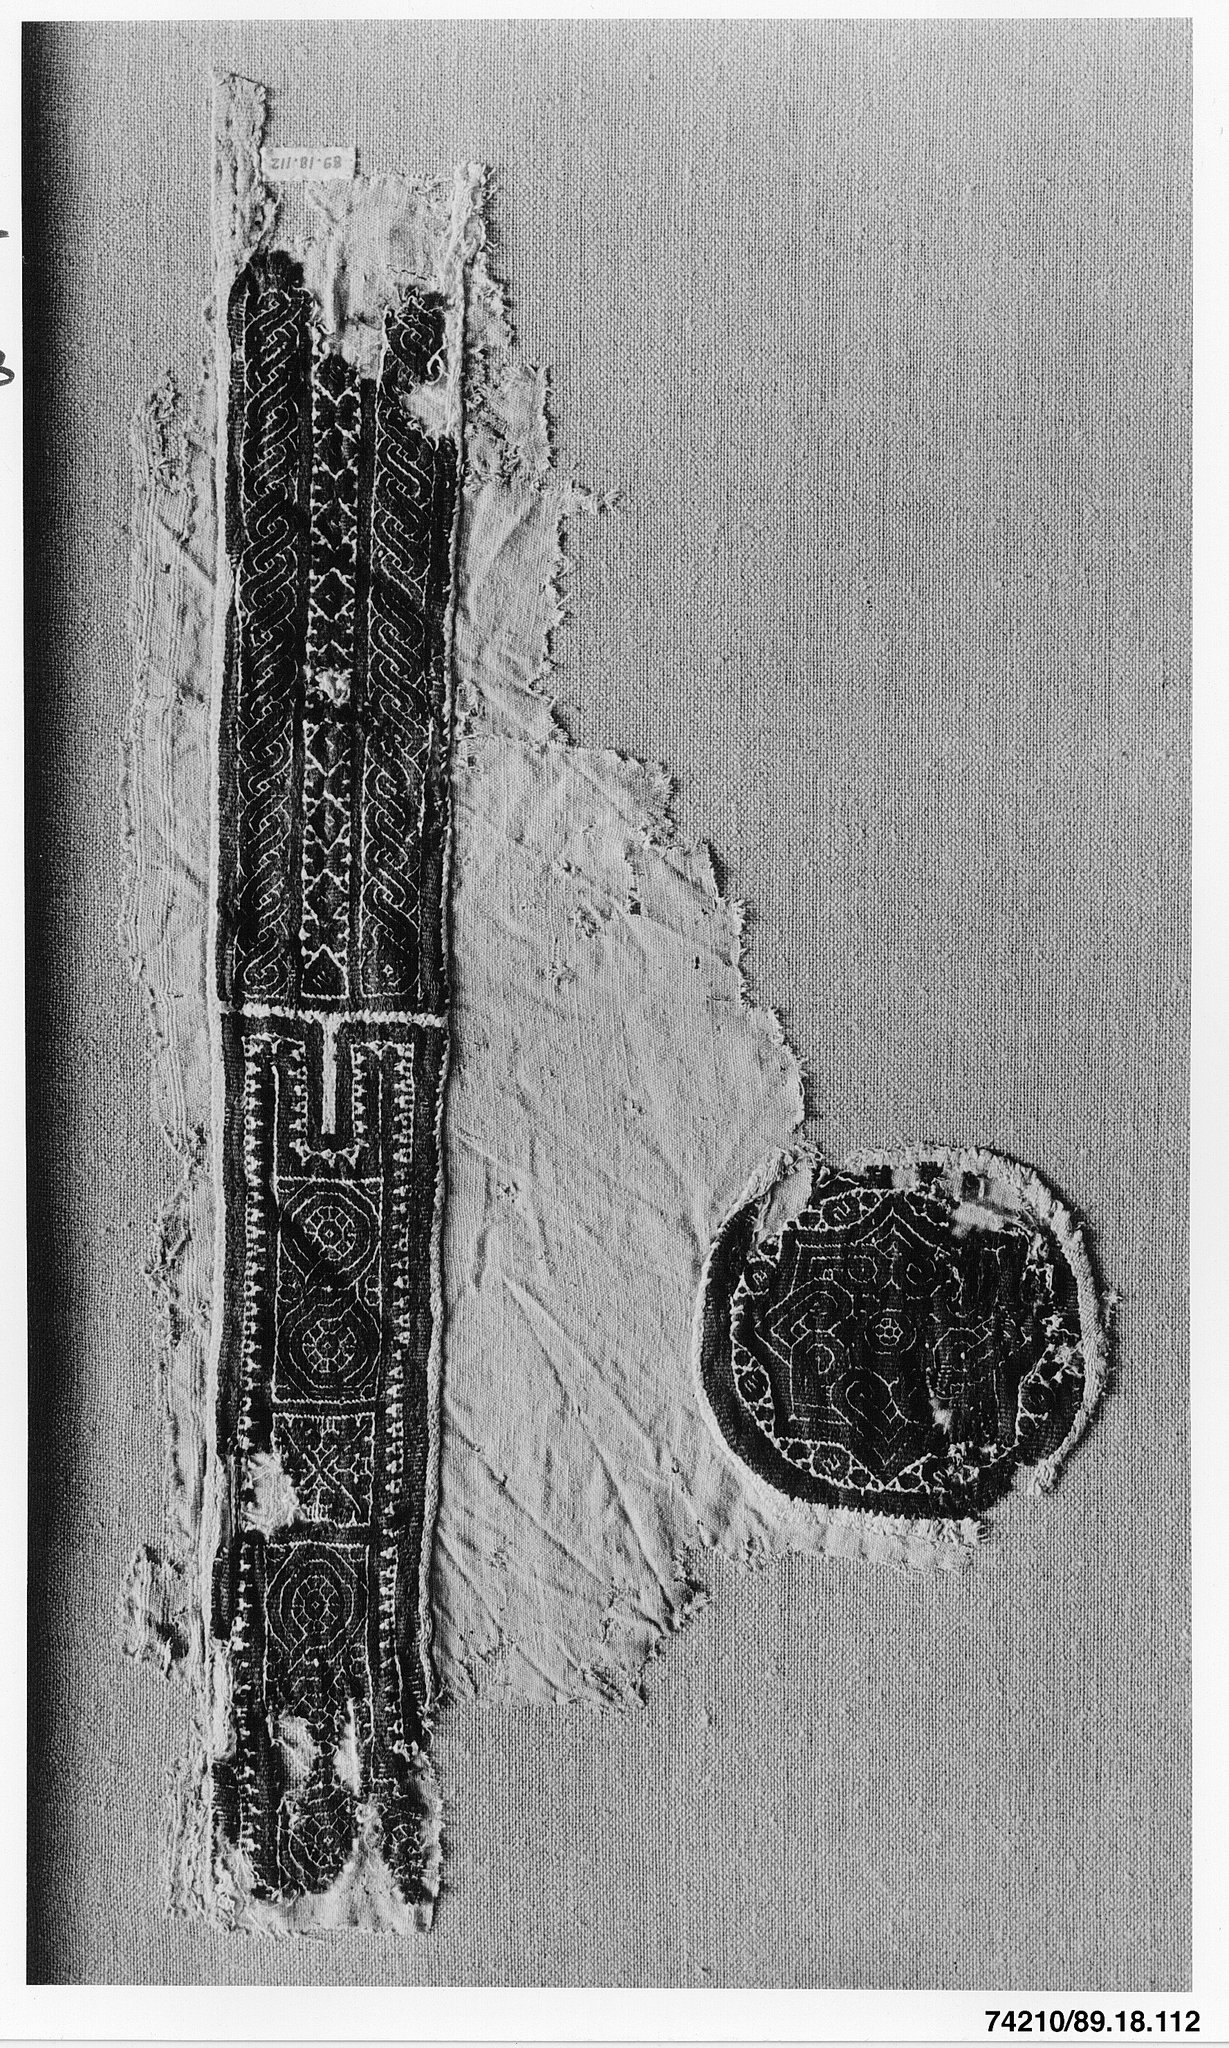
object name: textile fragment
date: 201-400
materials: linen, wool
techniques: weave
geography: egypt